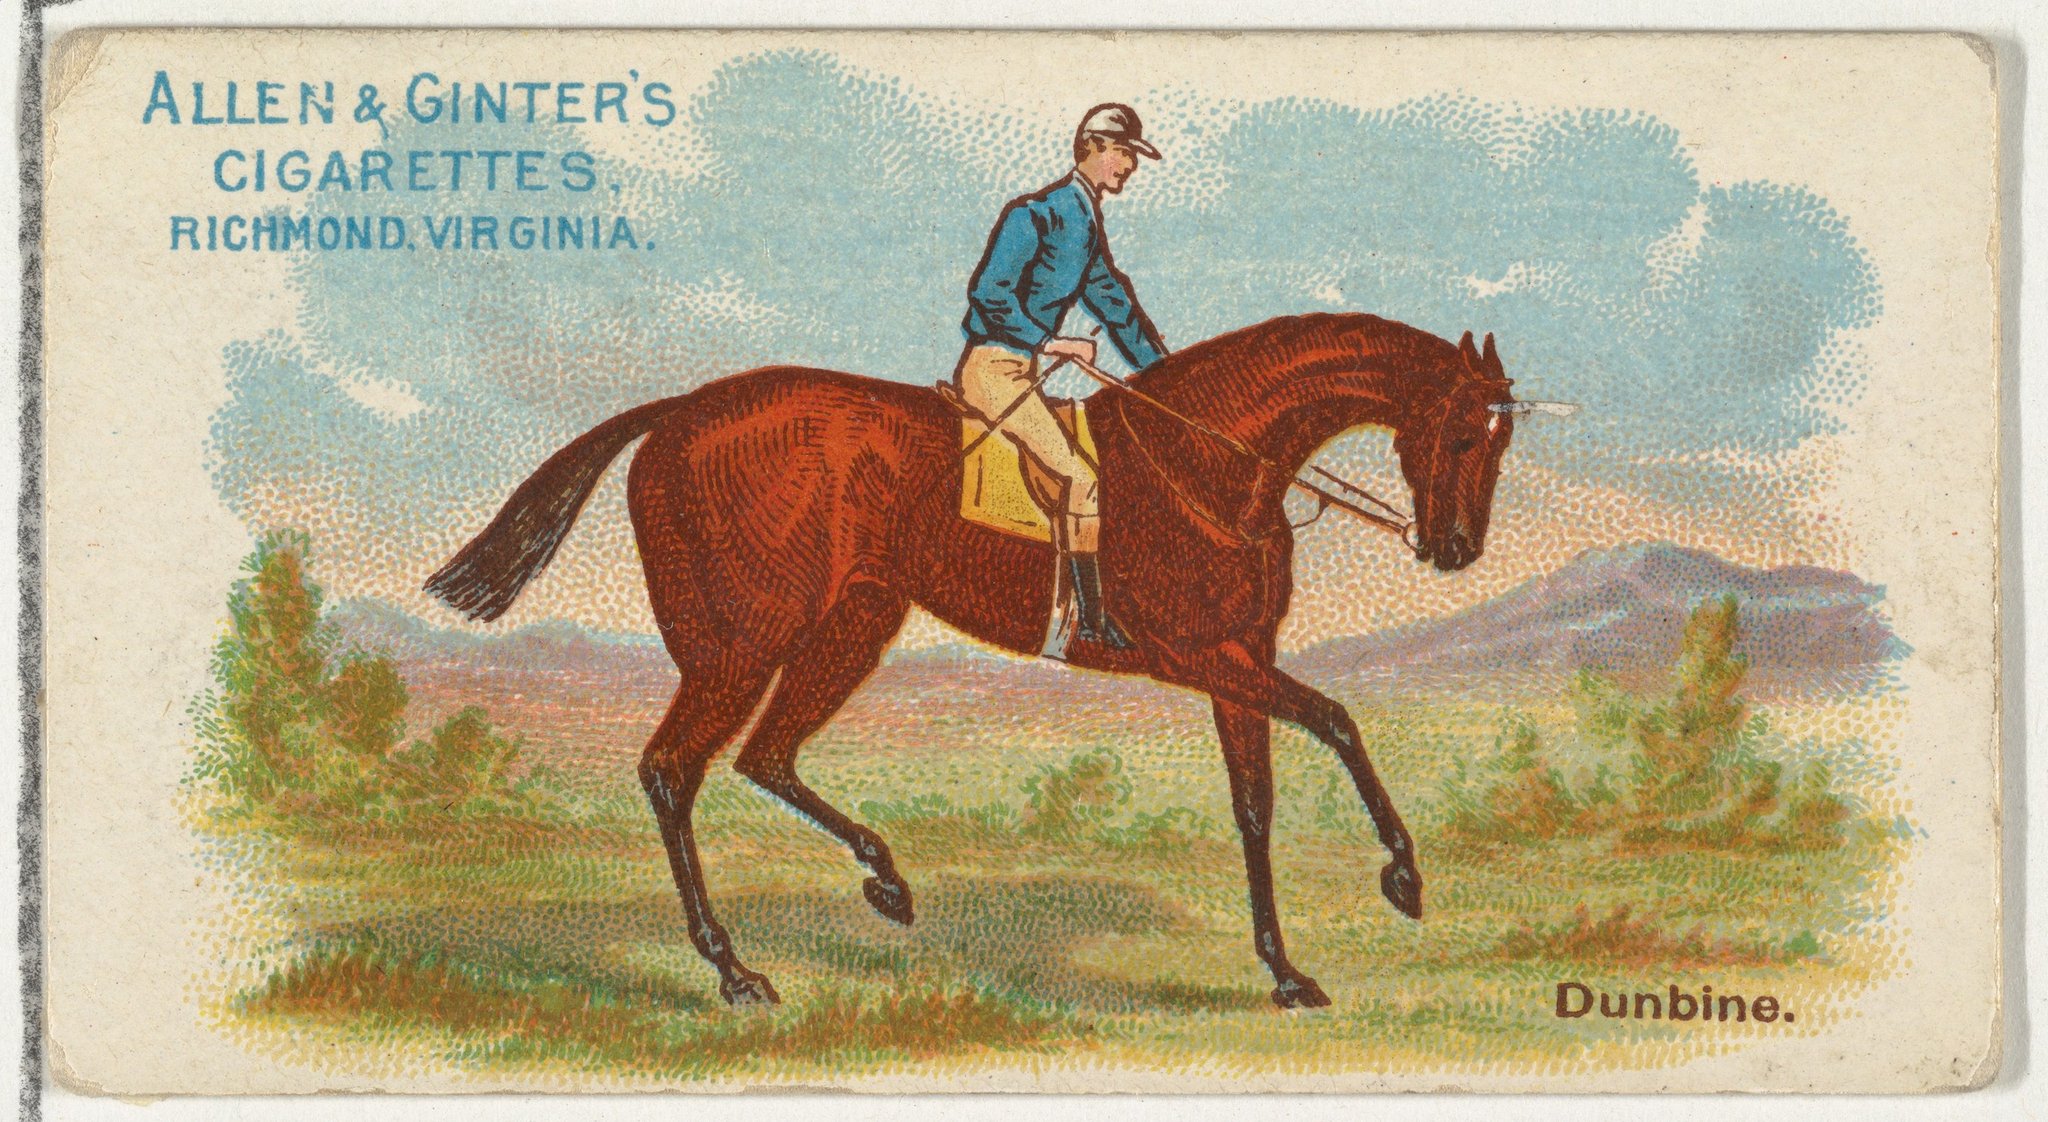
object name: print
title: Dunbine, from The World's Racers series (N32) for Allen & Ginter Cigarettes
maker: allen & ginter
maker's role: publisher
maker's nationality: american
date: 1888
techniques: color lithograph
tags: men,horses,jockeys